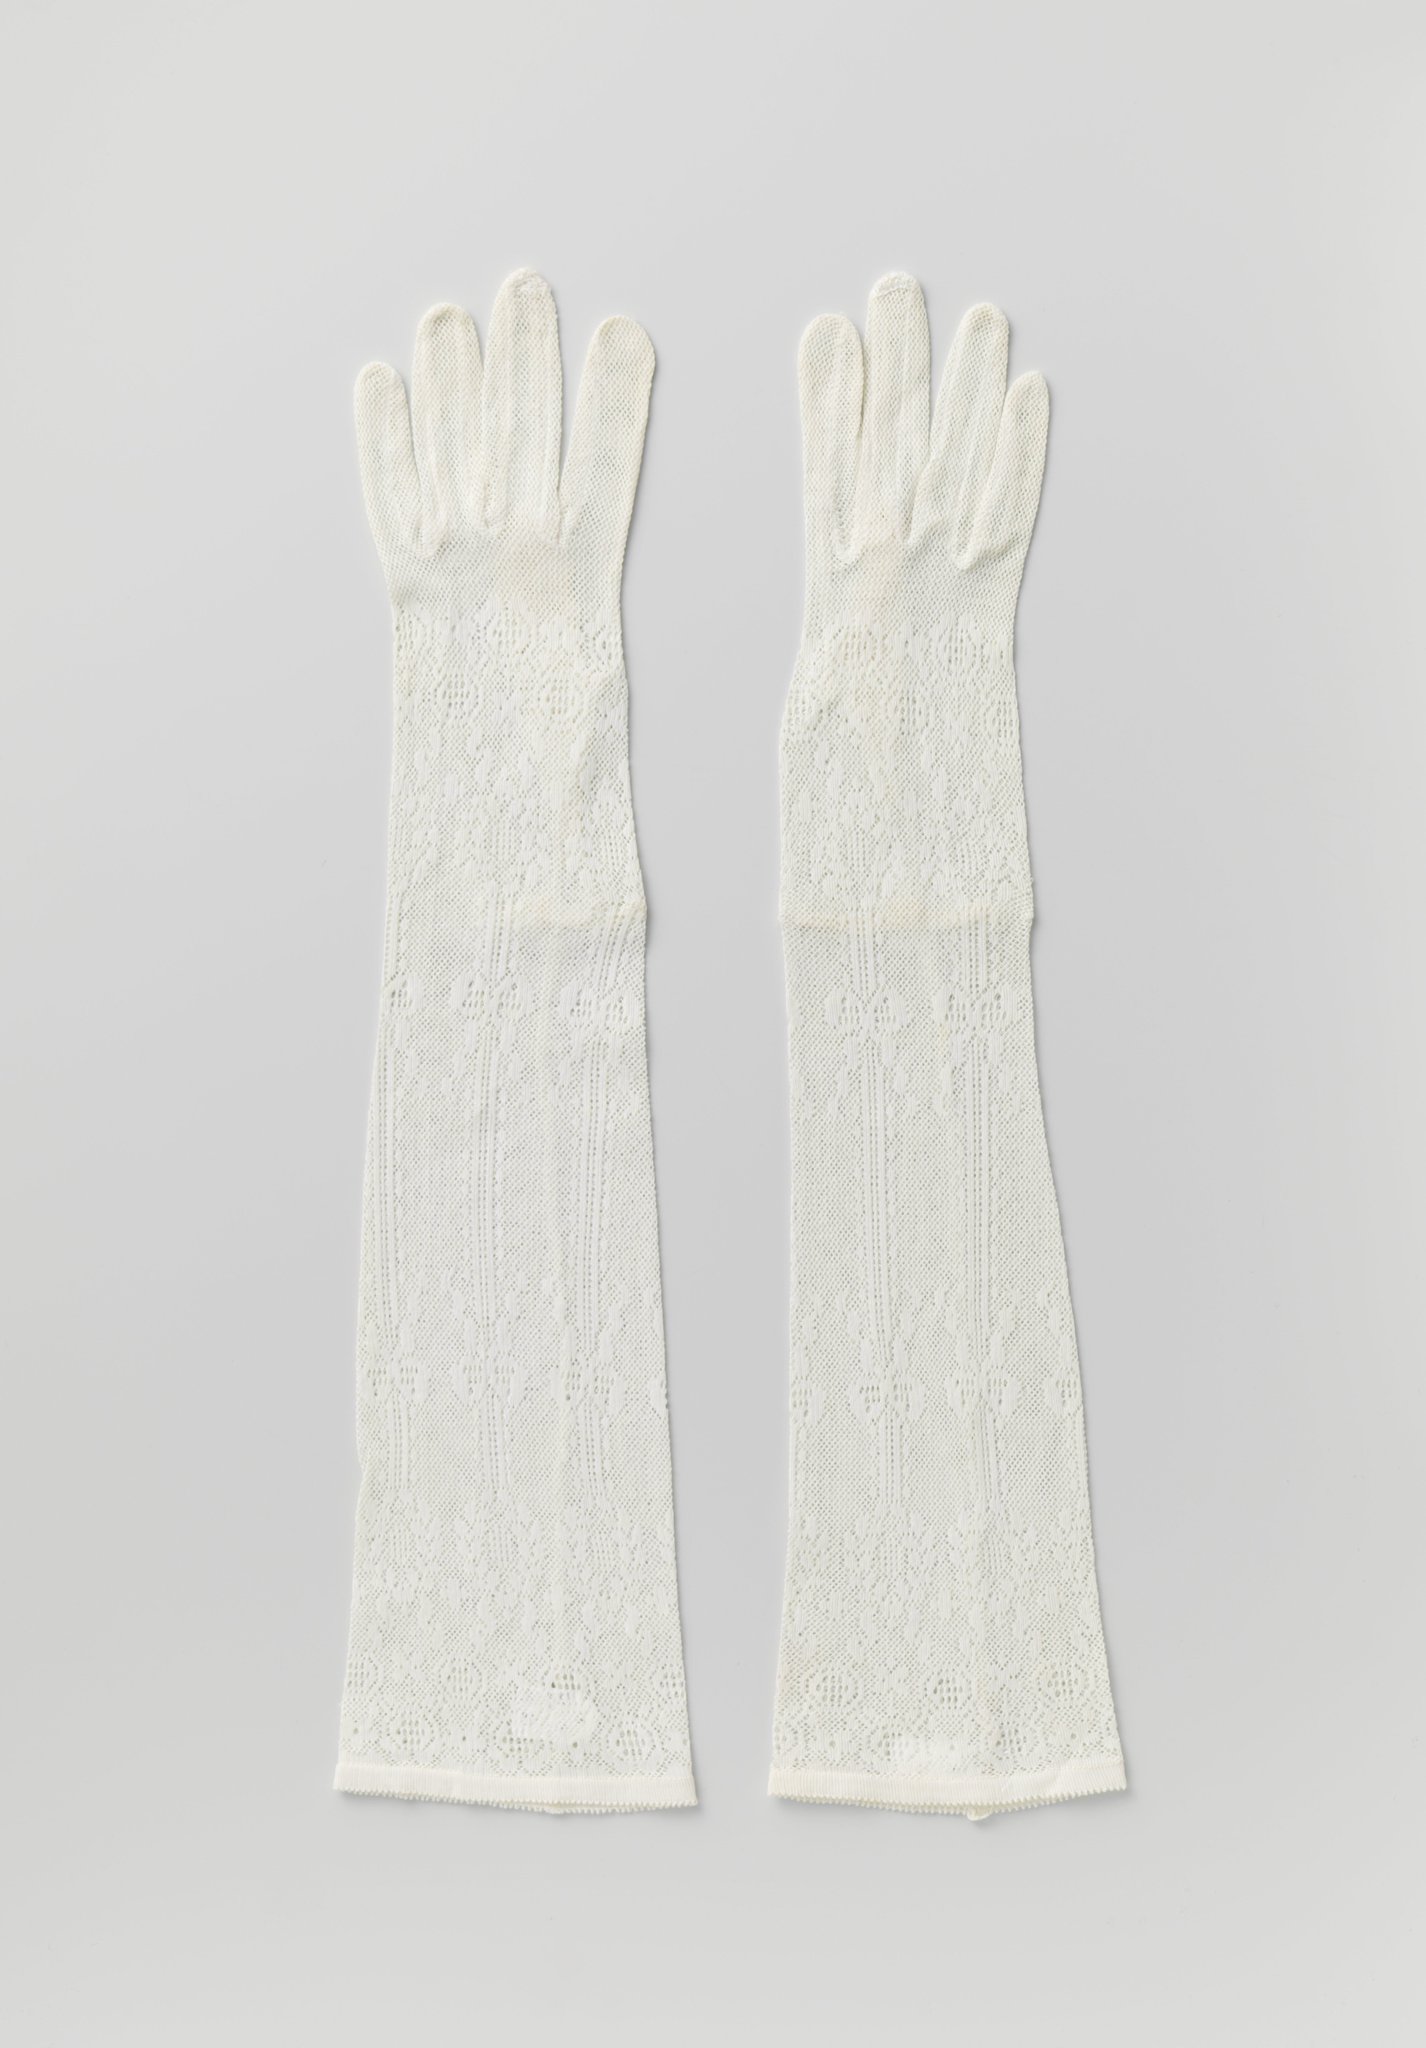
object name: glove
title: Handschoen van wit machinaal breiwerk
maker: Anonymous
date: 1925-1935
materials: cotton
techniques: knitting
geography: western europe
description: Paar lange dameshandschoenen van uit machinaal kantwerk. Bij de pols een elastiekje. Patroon. Bovendien de vingers van fijne mazen staan lange pijlen versierd met twee knopen en overgaand en beide einden in een dwarsrand met rasterwerk en rondjes.